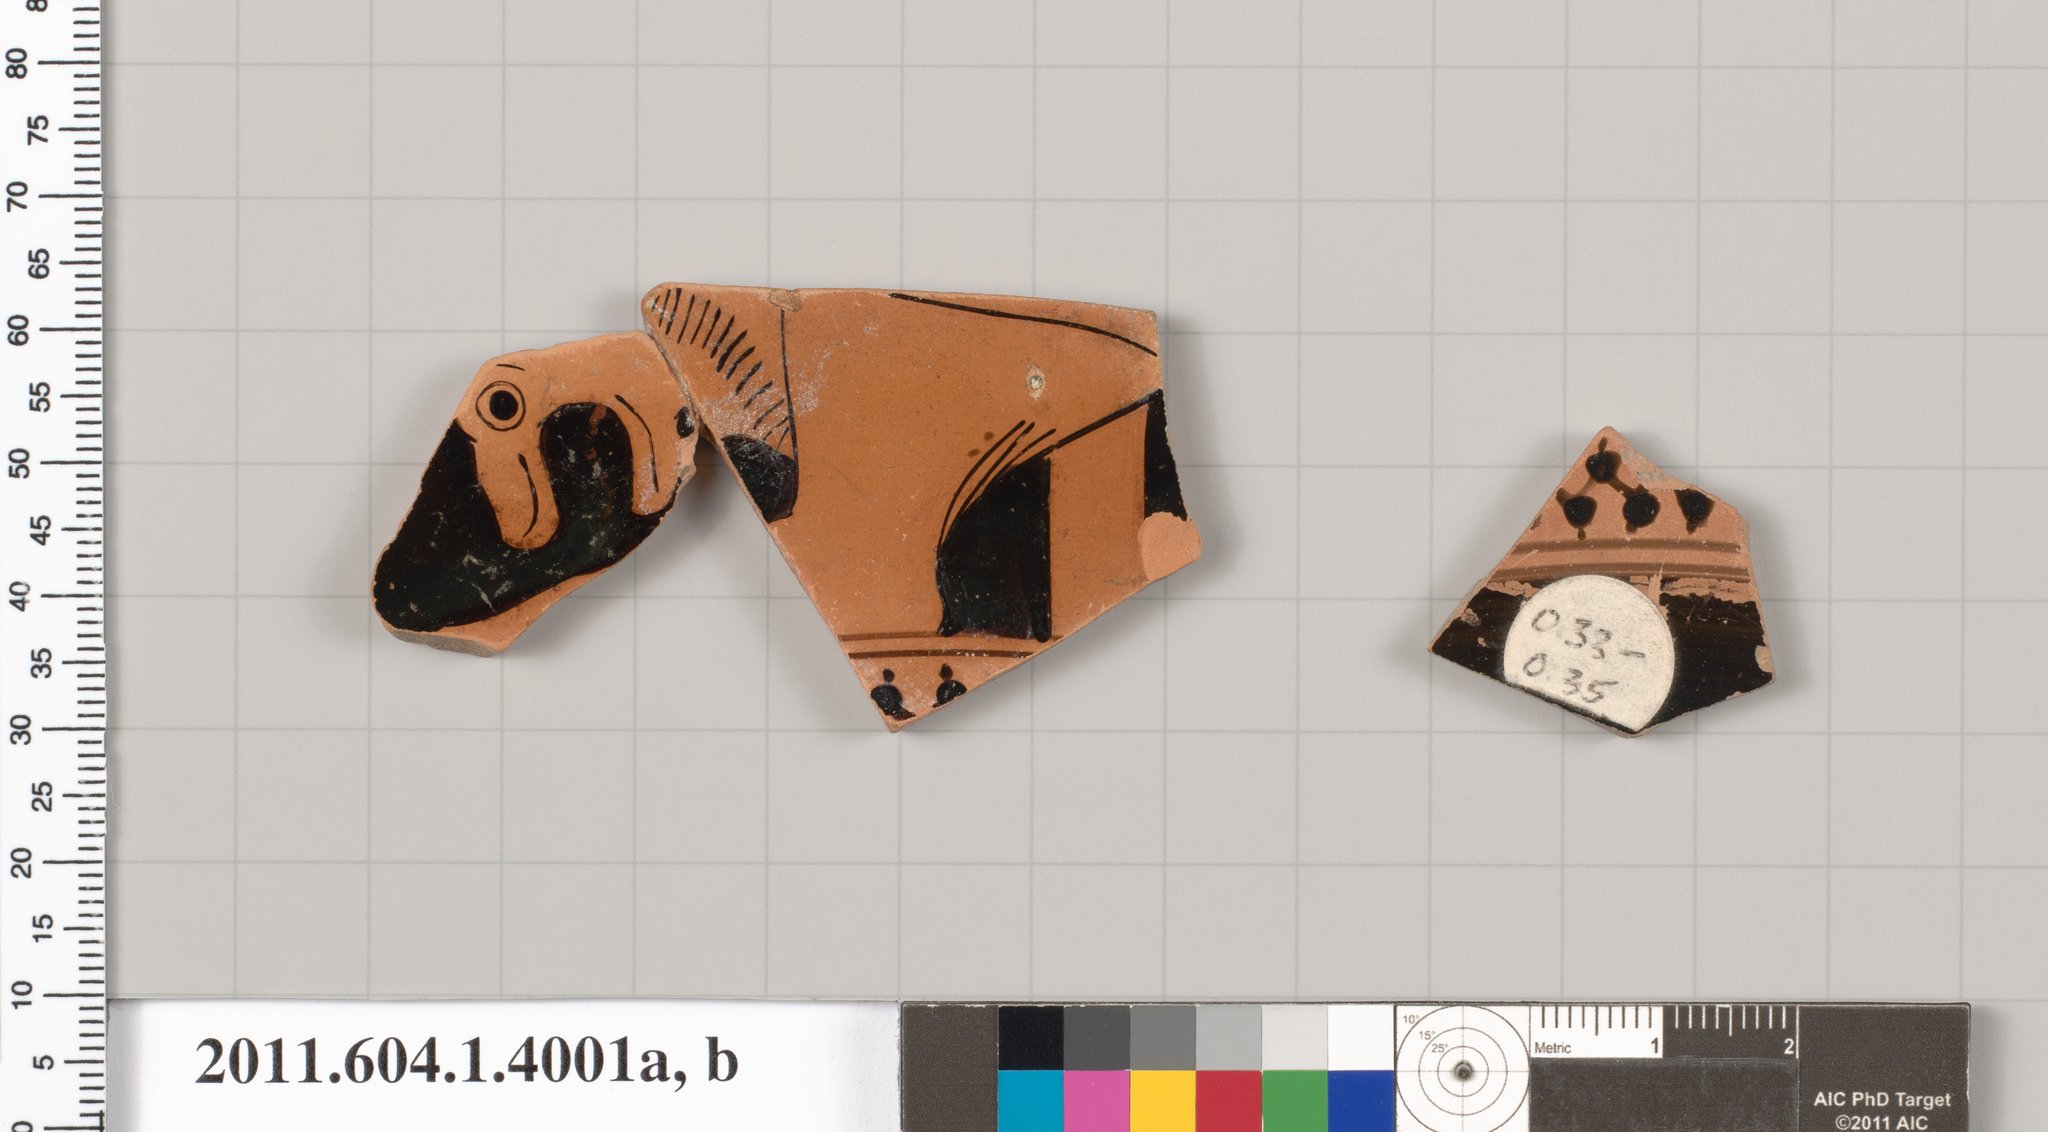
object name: kylix fragment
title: Terracotta fragments of a kylix (drinking cup)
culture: greek, attic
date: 567-600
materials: terracotta